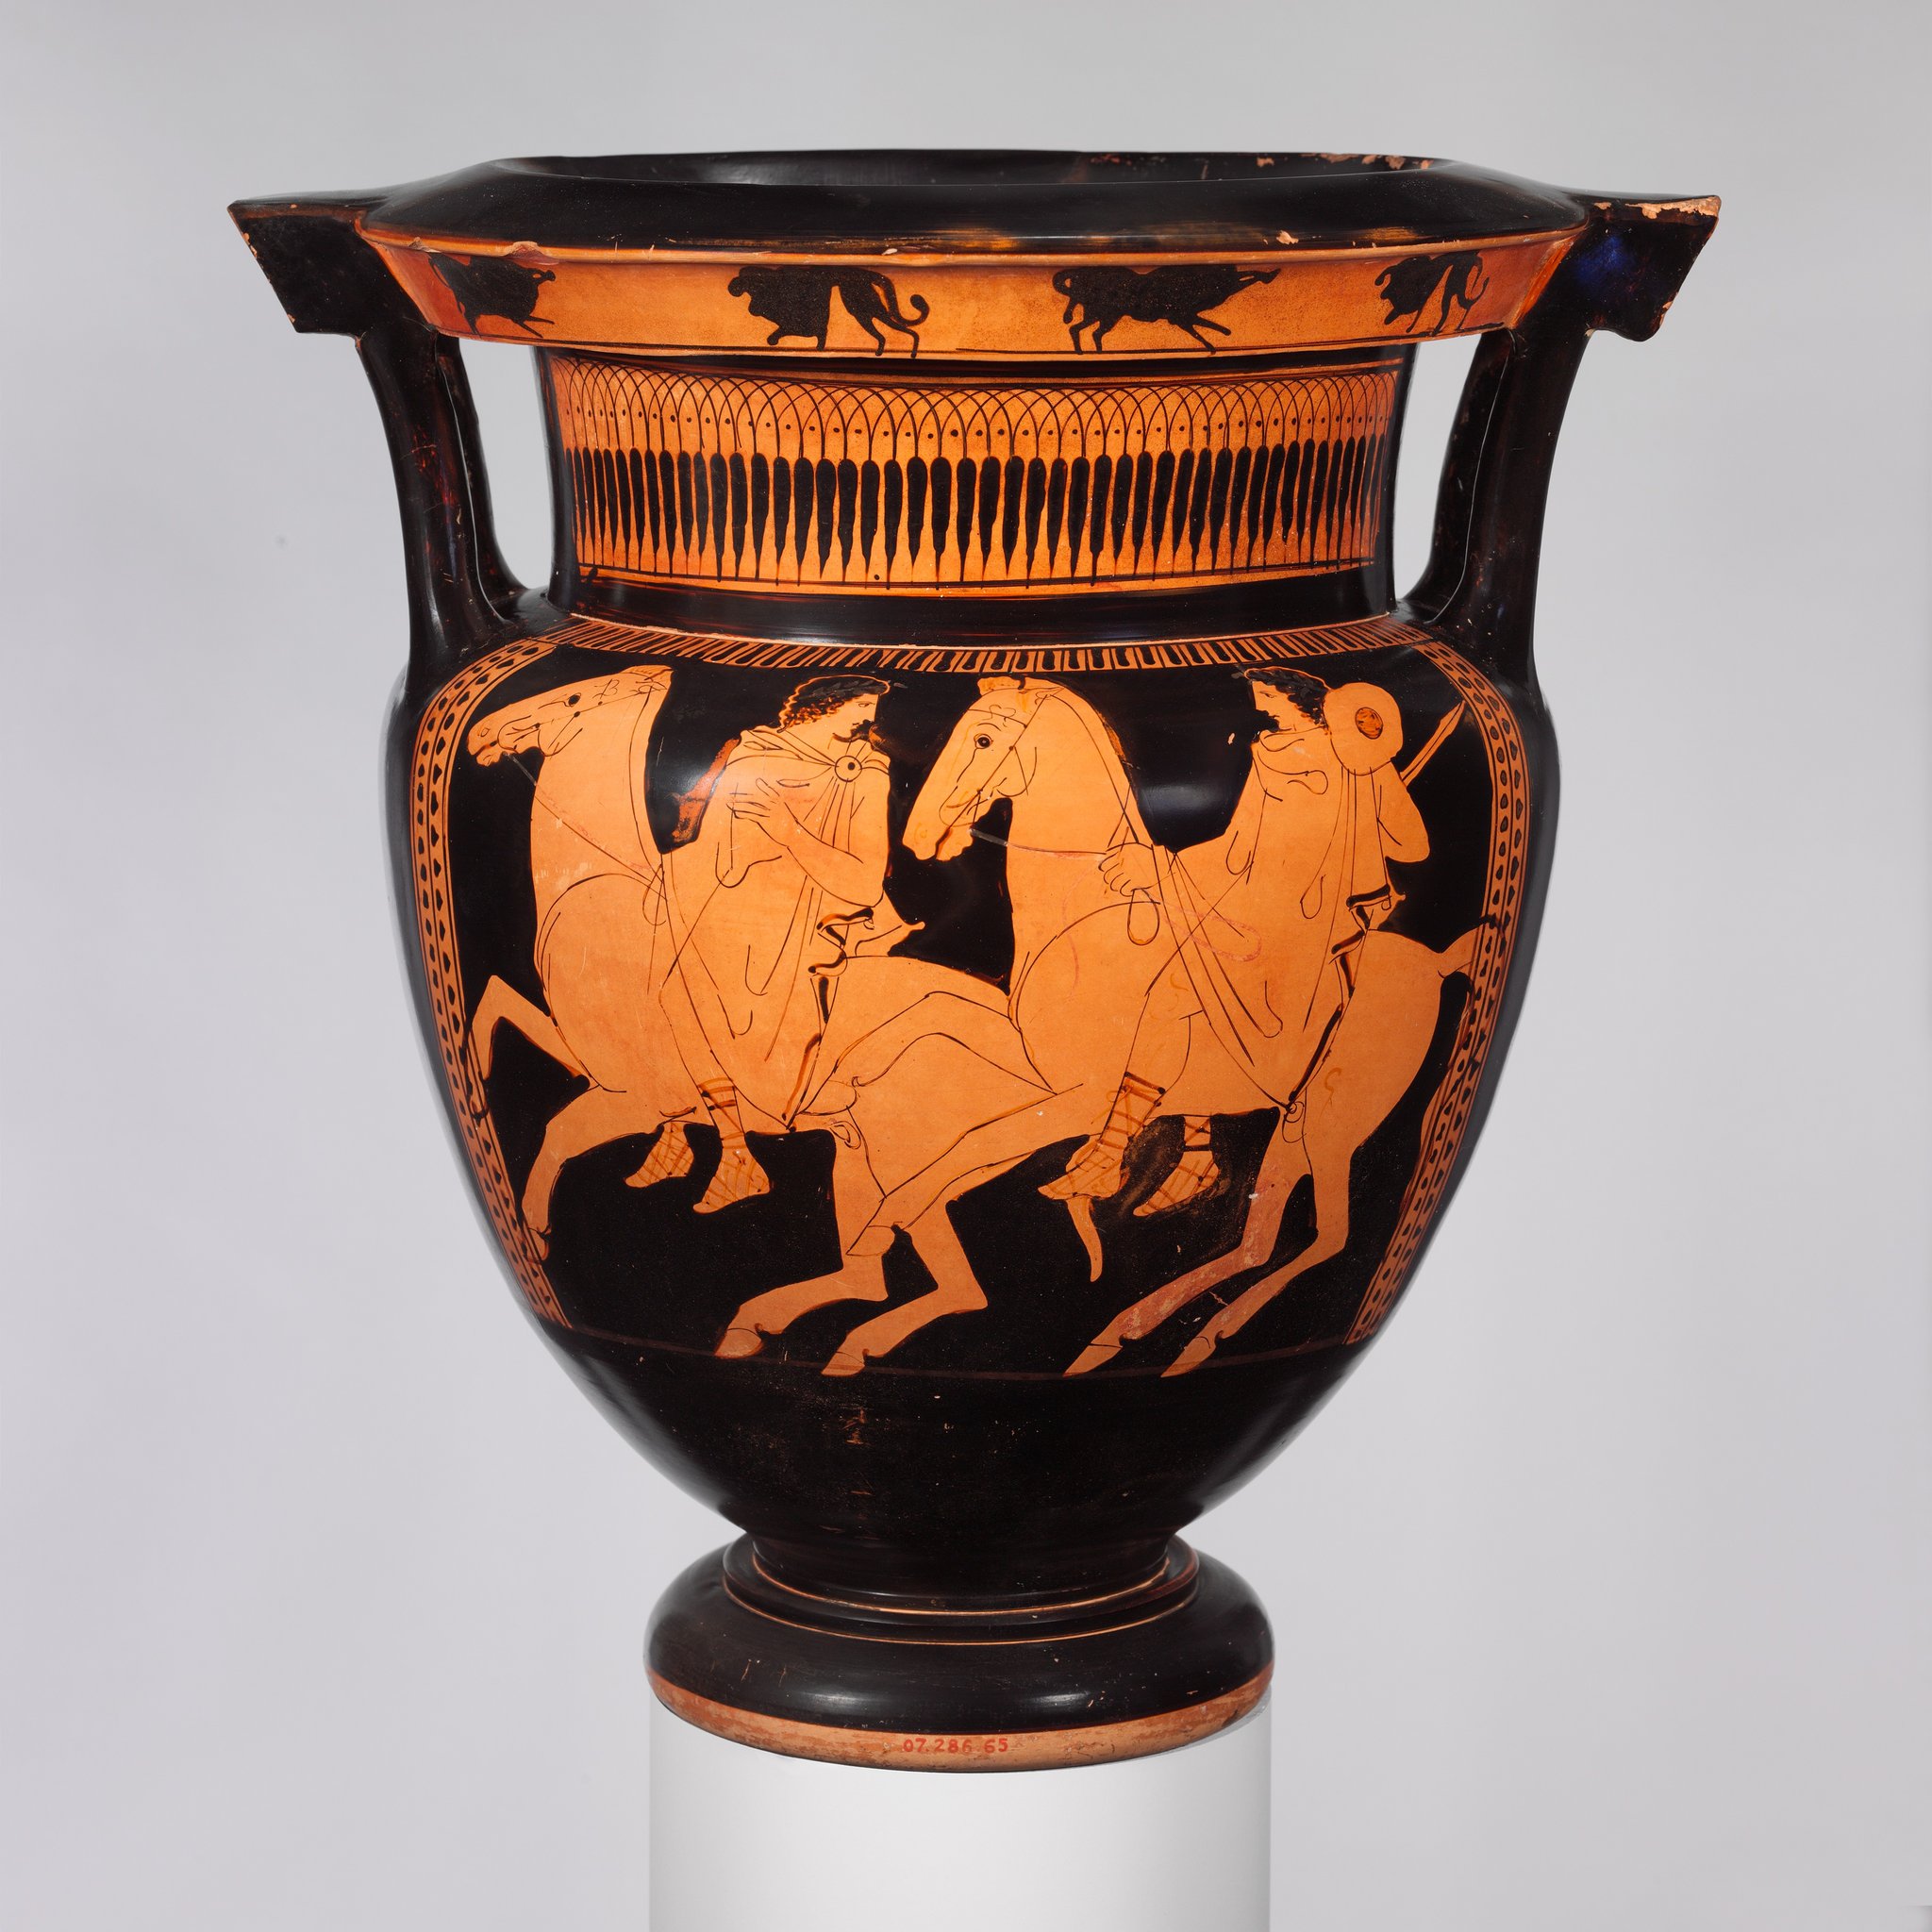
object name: column krater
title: Terracotta column-krater (bowl for mixing wine and water)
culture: greek, attic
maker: marlay painter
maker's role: artist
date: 430 BCE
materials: terracotta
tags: men,horses